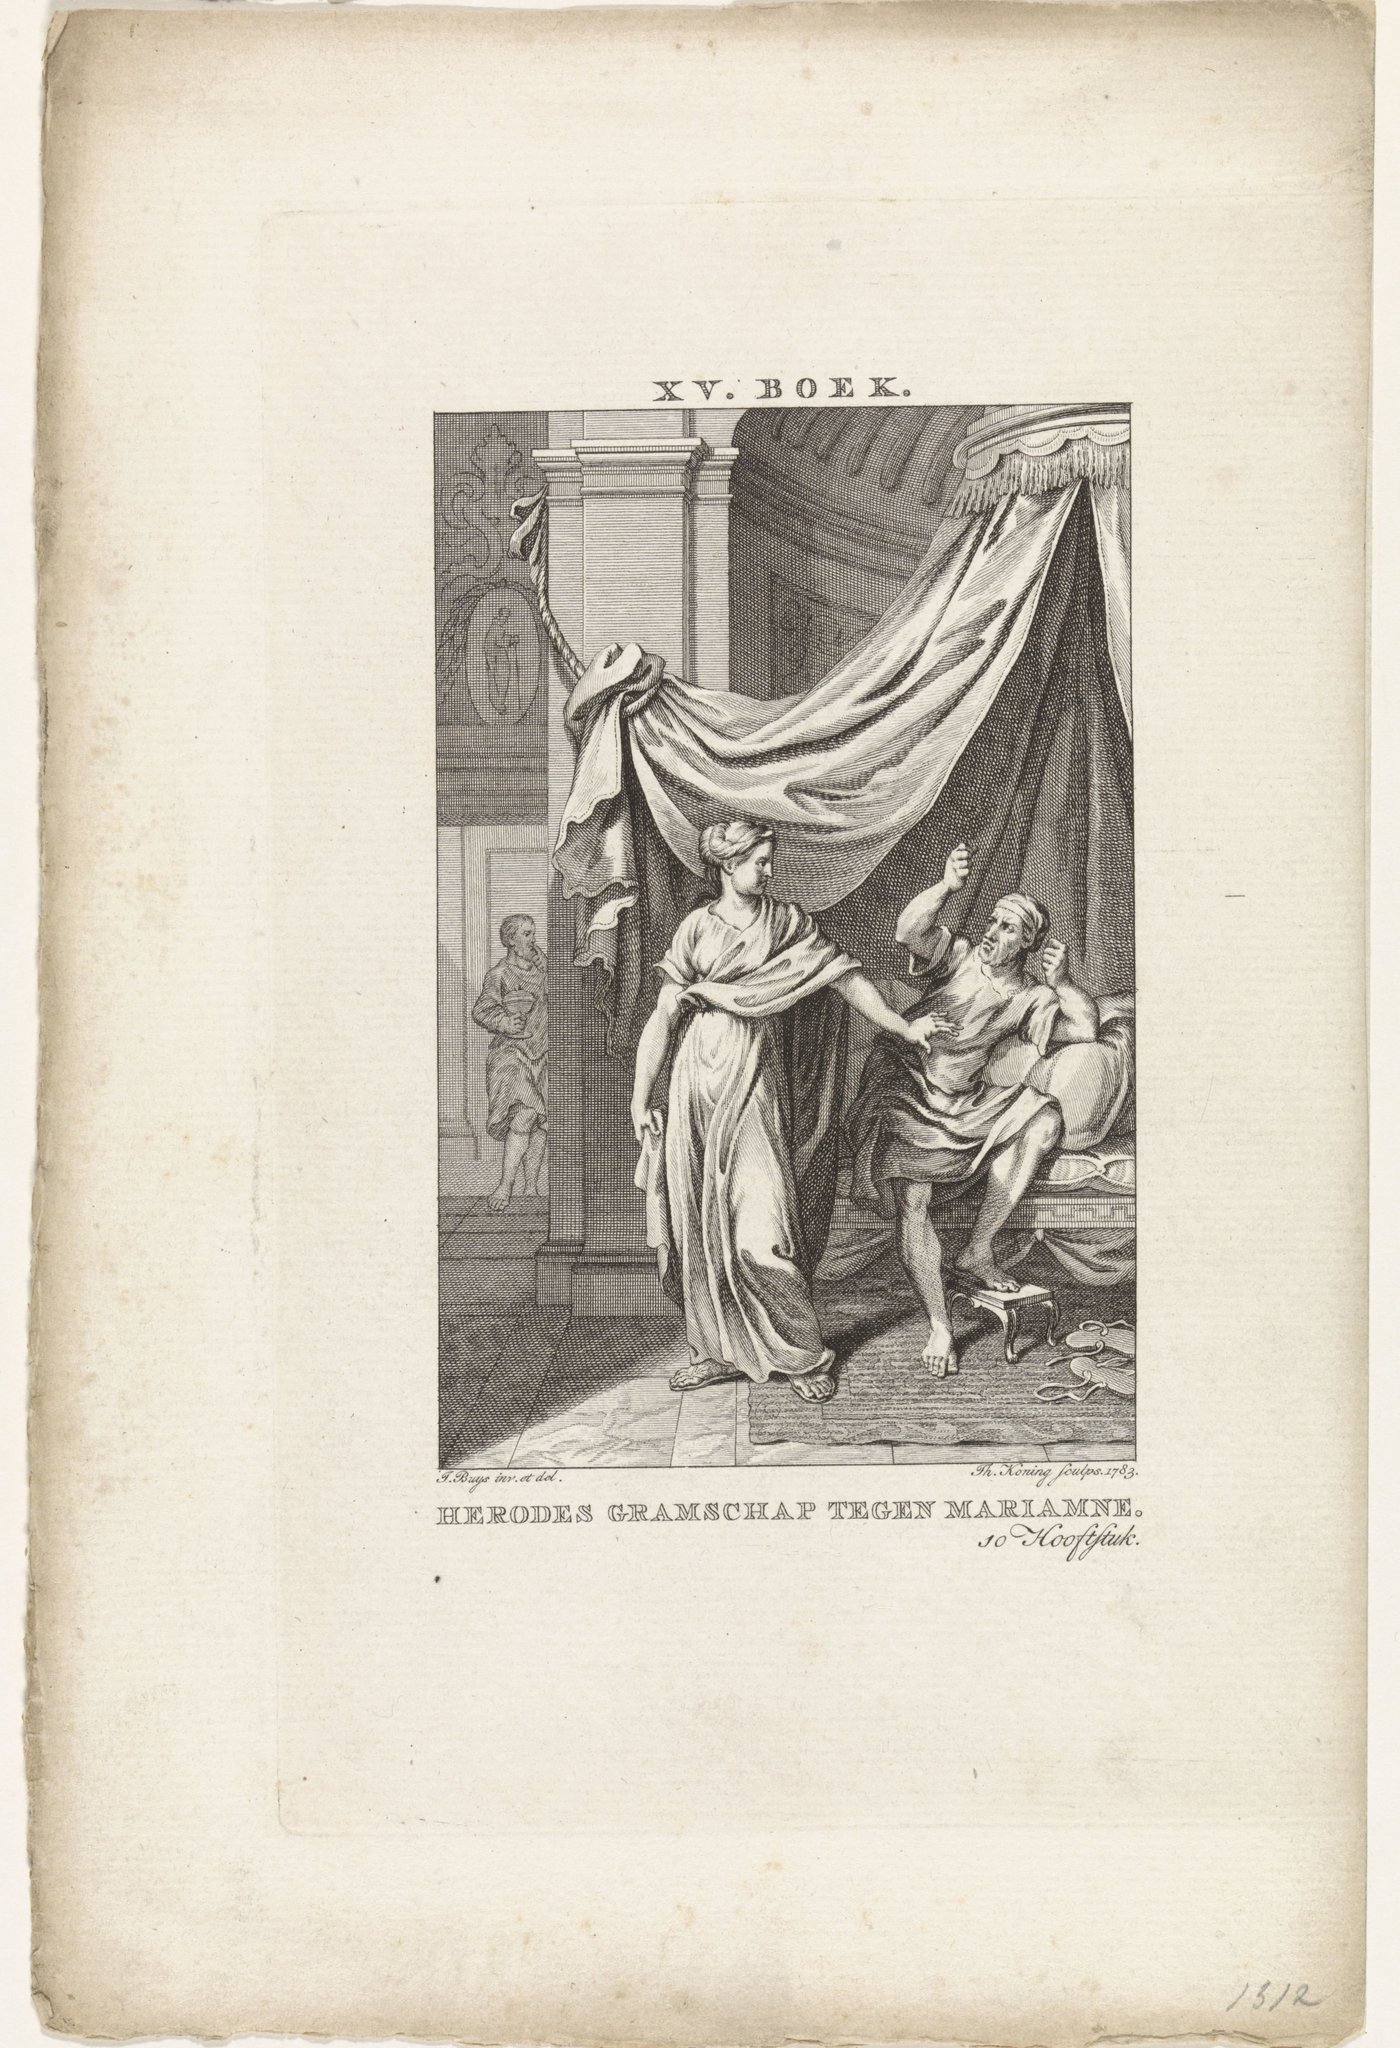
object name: book illustration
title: Herodes gramschap tegen Mariamne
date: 1783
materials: paper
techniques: engraving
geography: amsterdam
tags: herod (not in biblical context)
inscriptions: collector's mark: Lugt 2228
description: In een gedecoreerd vertrek heft Herodes, zittend op de rand van een bed, woedend zijn gebalde vuisten naar zijn vrouw Mariamne omdat zij haar huwelijkse verplichtingen niet nakomt. Mariamne spreekt haar woede uit over de moord op haar grootvader en keert Herodes de rug toe. Op de achtergrond staat een man die zijn wijsvinger tegen zijn lippen houdt en een vaas draagt. Deze prent is een illustratie bij het tiende hoofdstuk van het vijftiende boek van 'Alle de werken van Flavius Josephus'.